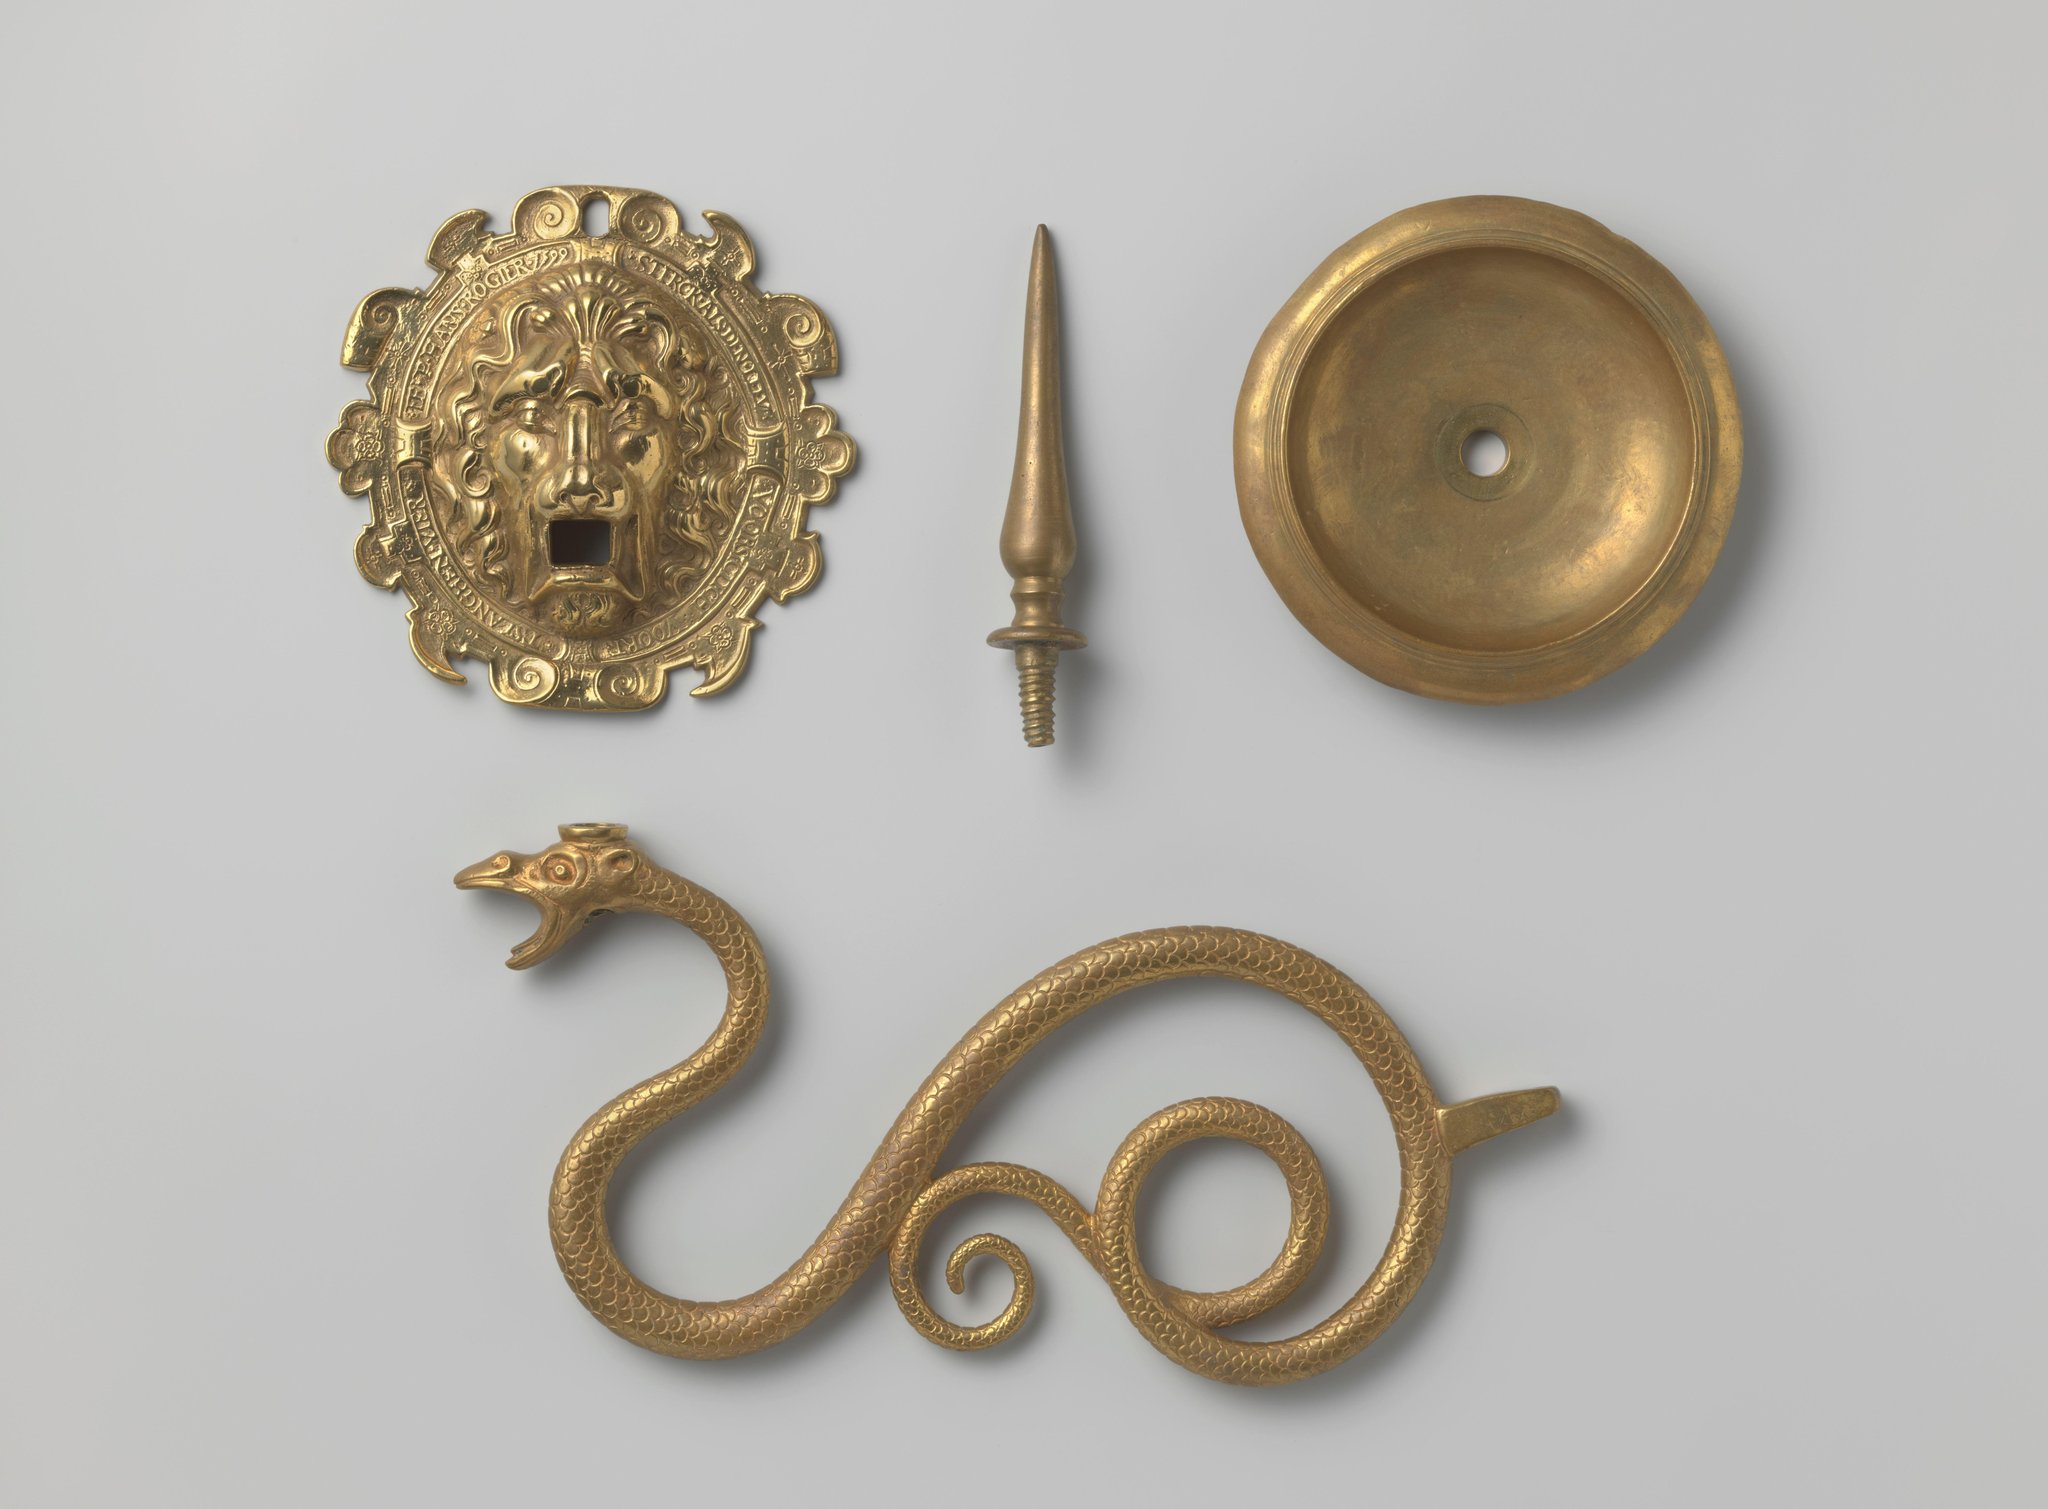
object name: wandplaat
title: Wandluchter met leeuwenkop en slang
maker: hans rogiers van harelbeke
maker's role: metalworkers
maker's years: -1638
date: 1599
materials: brass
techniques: casting, screwed, soldering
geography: amsterdam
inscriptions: inscription: ‘.STERCK.ALSDEN.LEEV. / VOORSICTICH.VOORT. / .TSLANGHEN.VIER. / .FE.HANS.ROGIER.1599.’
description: Het voorwerp bestaat uit vier gegoten delen: de wandplaat, de arm, de vetvanger, de kaarsenpin. De wandplaat is uit dezelfde vorm gegoten als die van BK-BR-946-S, heeft de vorm van een leeuwenkop met opengesprerde bek, waarin een vierkant gat. Daaromheen een in vieren gedeelde spreukband met de naam en het opschrift .STERCK.ALSDEN.LEEV. / VOORSICTICH.VOORT. / .TSLANGHEN.VIER. / .FE.HANS.ROGIER.1599. Daaromheen een rolwerkornament, waarop verschillende versieringen zijn geponst, o.a. vierbladige roosjes. Bovenaan is een gat aangebracht. Aan de achterkant is een oog gesoldeerd. De arm is uitgevoerd als een in een S-vorm gekronkelde geschubde slang. Deze is in het staartdeel voorzien van een uitsteeksel, dat past in de bek van de leeuw van de wandplaat. In de kop met opengesperde bek is een gat aangebracht, waarin de kaarsenpin kan worden geschroefd. De ronde vetvanger heeft een geprofileerde rand en onderkant. De kaarsenpin heeft de vorm van een in een punt toelopende baluster.